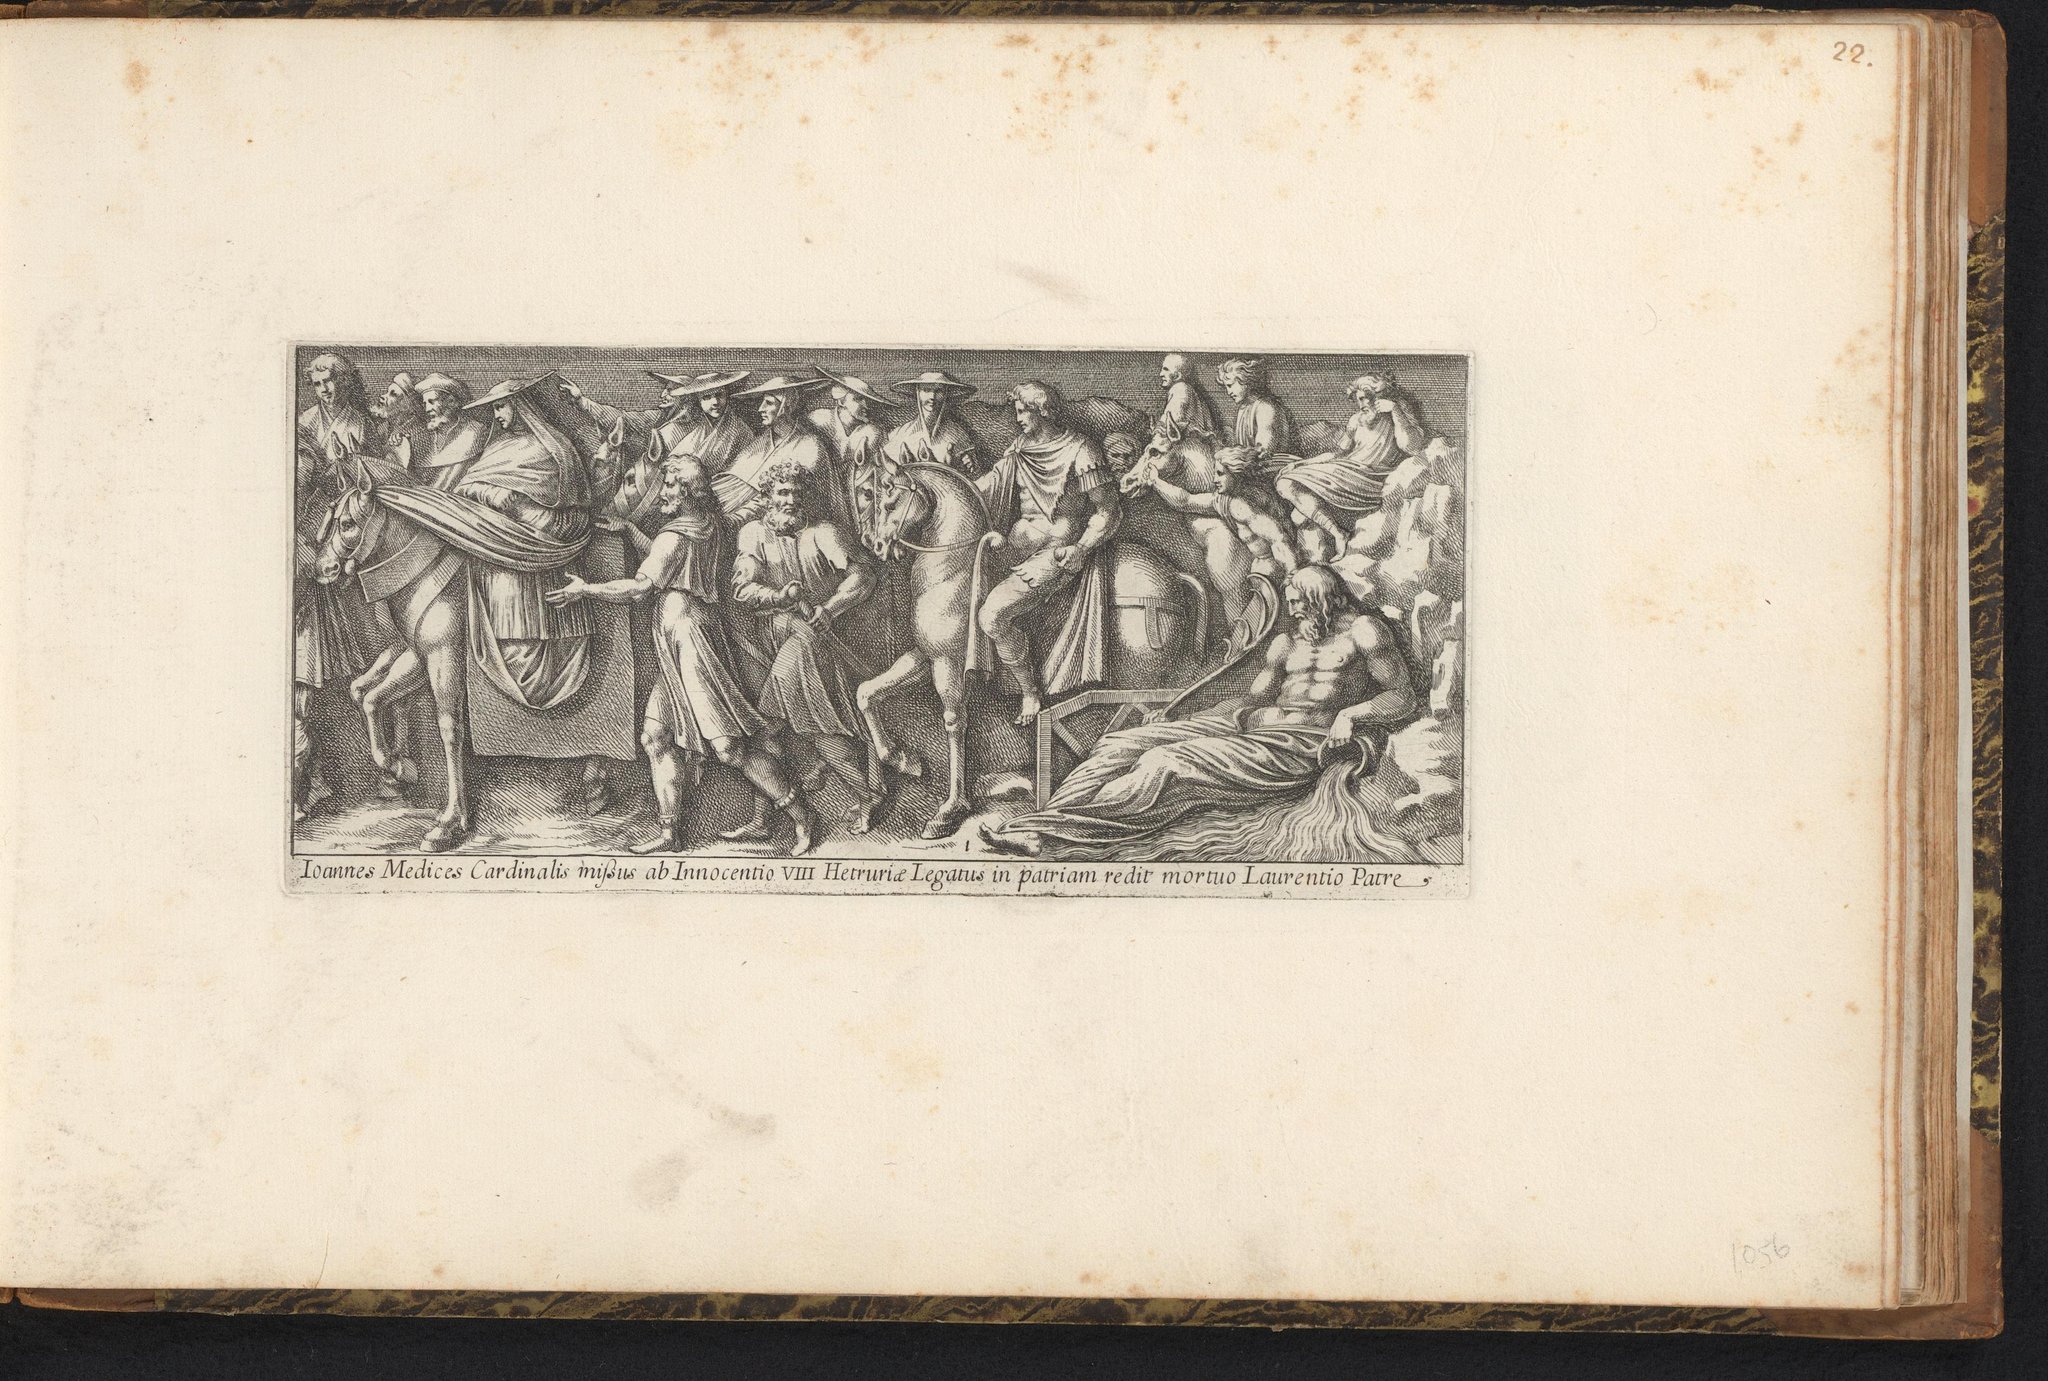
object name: album leaf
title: Scènes uit het leven van paus Leo X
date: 1645-1700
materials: paper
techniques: engraving, etching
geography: vatican city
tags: rome, leo x, riding a horse, ass, or mule; rider, horseman, cardinal, arrival and return ~ travelling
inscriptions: number: ‘22’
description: Giovanni de' Medici keert terug naar huis na de dood van zijn vader. Hij rijdt richting Florence op zijn paard, vergezeld door een processie van geestelijken te paard. Rechts een liggende riviergod. Titel in ondermarge. Genummerd midden onder: 1. Prent maakt deel uit van een album.